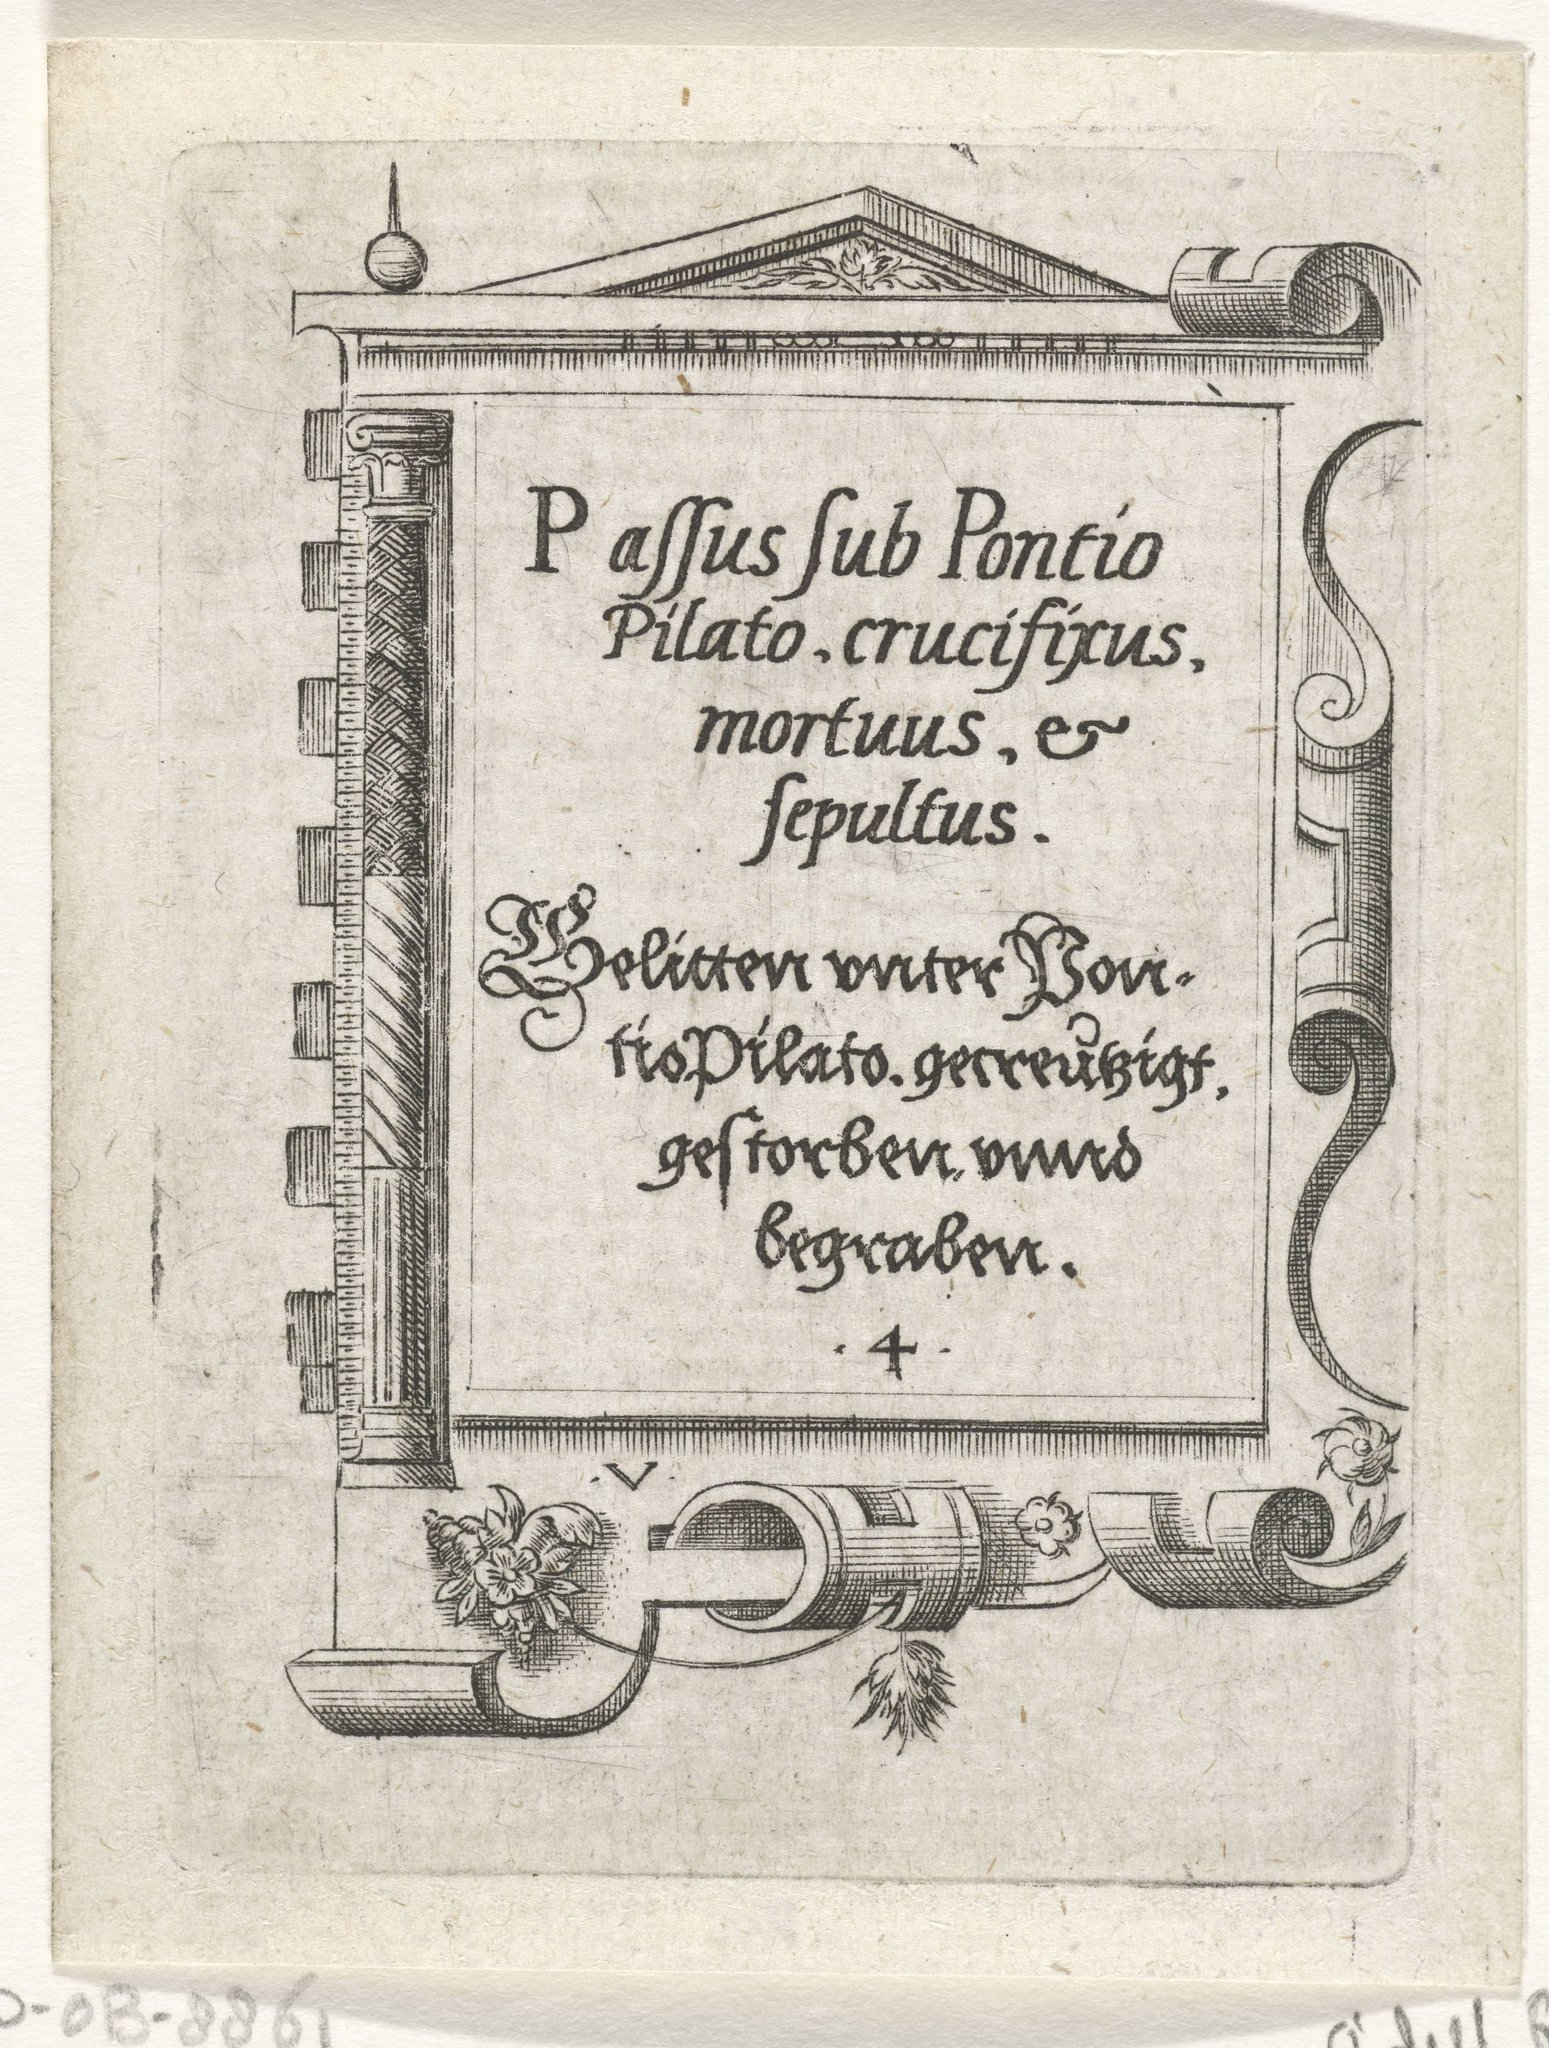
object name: print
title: Tekst: Passus sub (...)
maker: virgilius solis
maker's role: draughtsman, print maker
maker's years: 1514-1562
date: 1524-1562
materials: paper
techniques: engraving